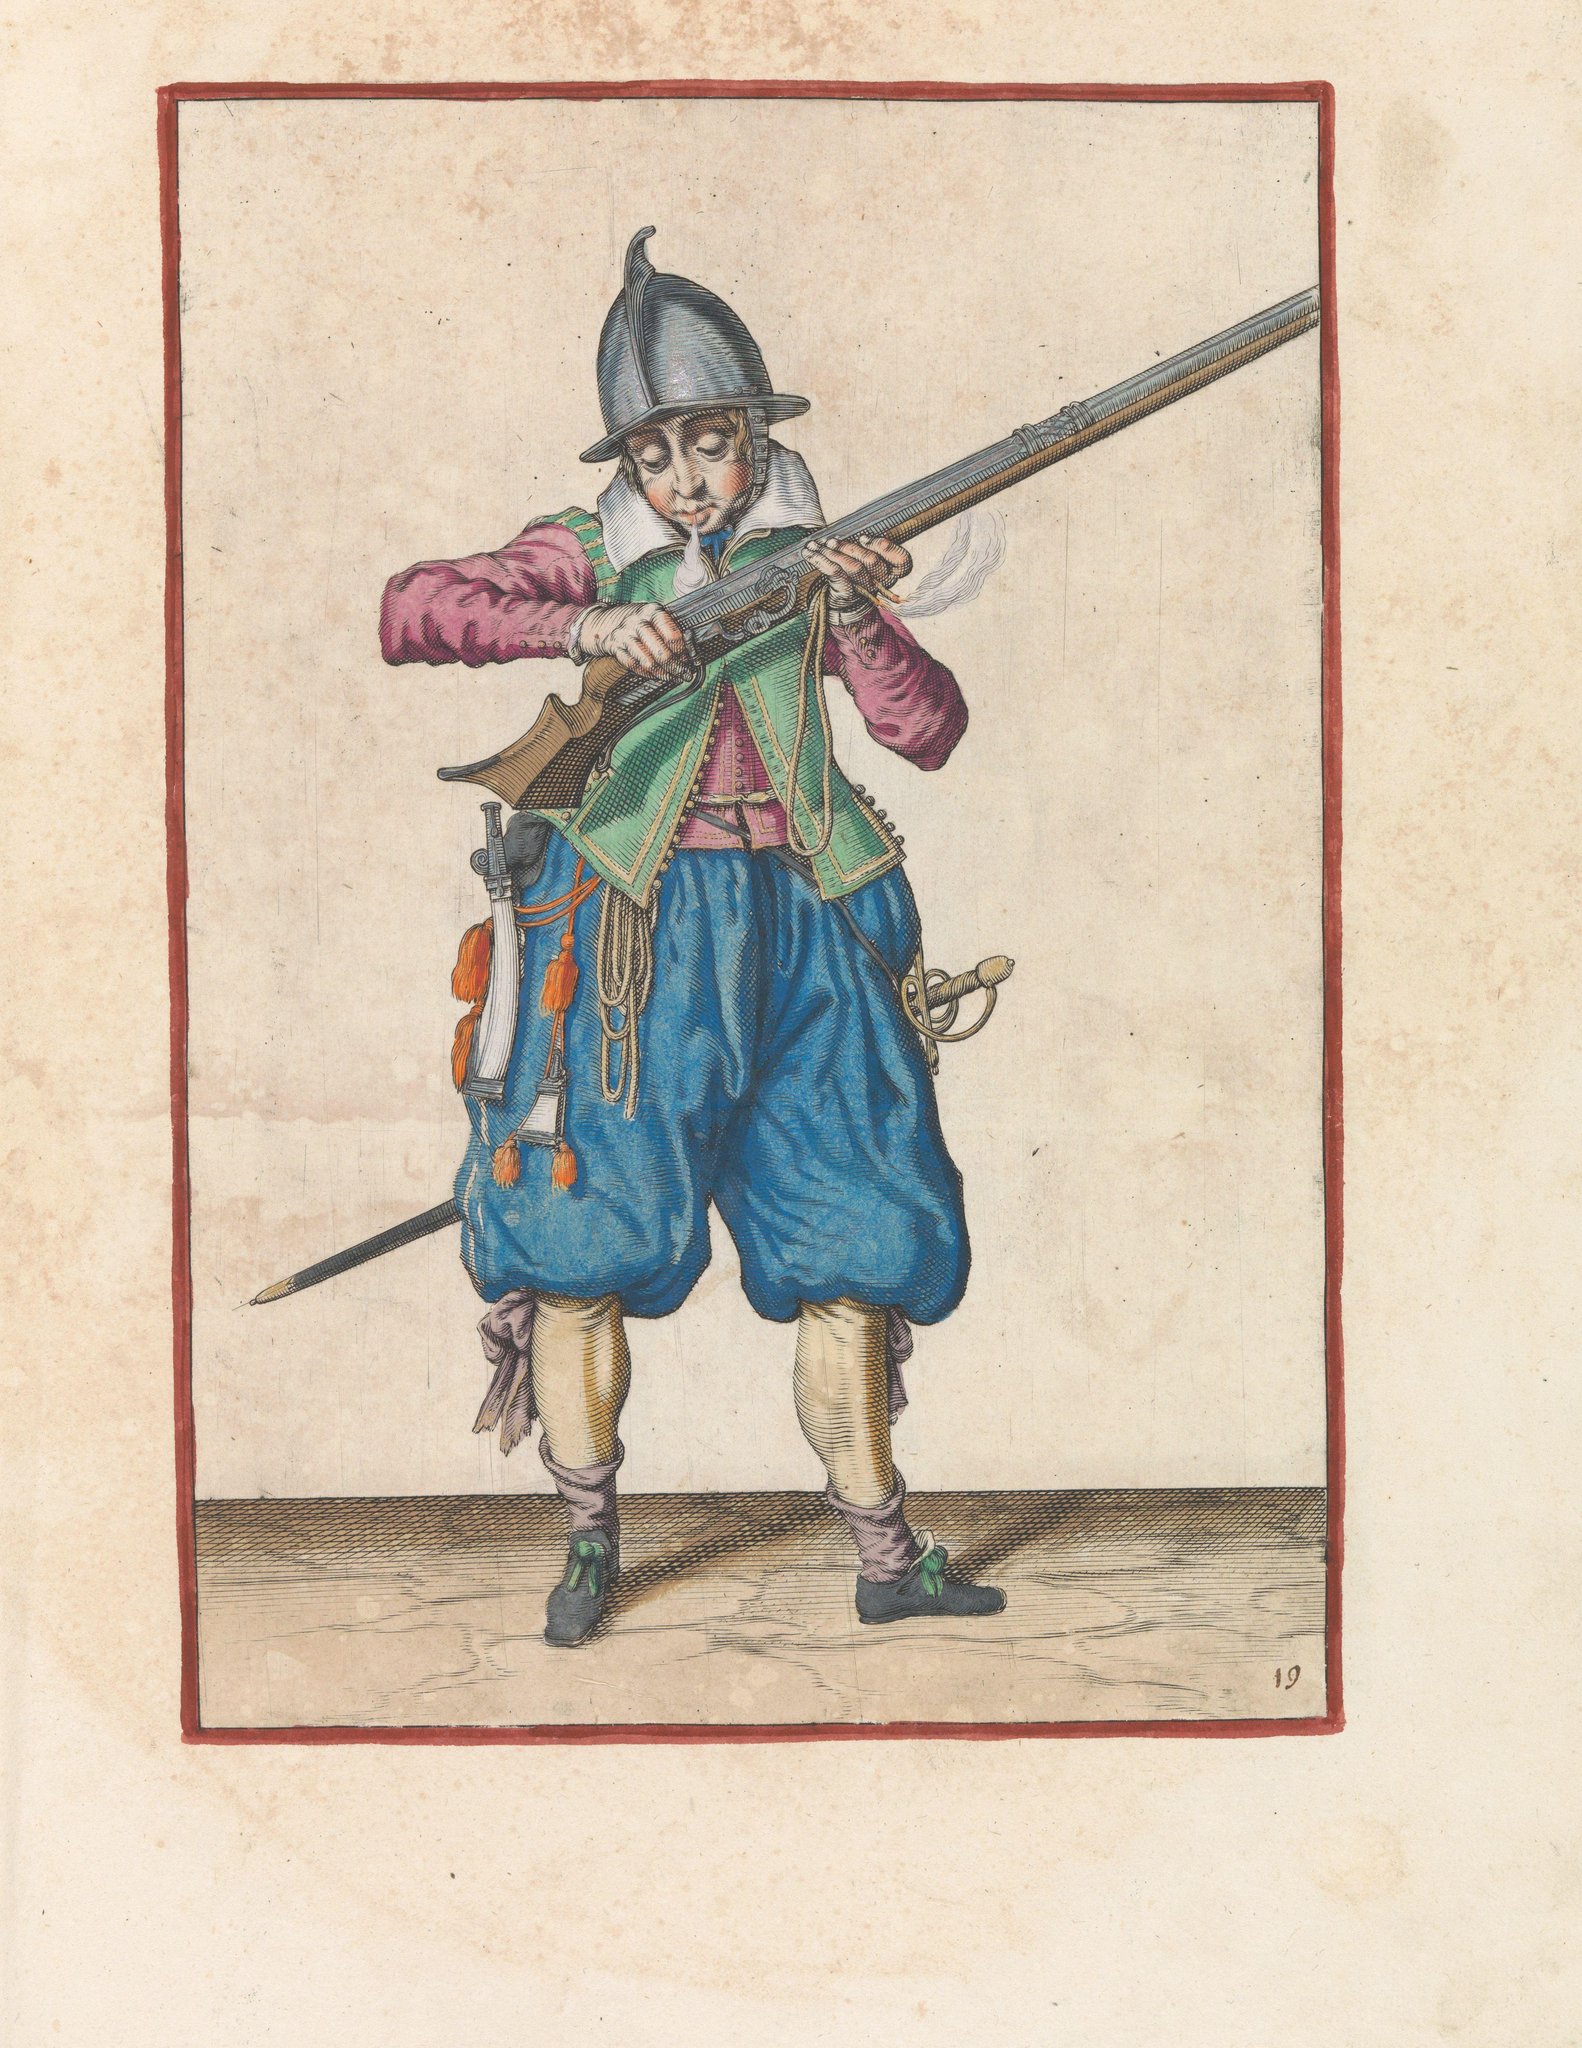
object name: print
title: Corte onderwysinghe op de figuerliicke afbeeldinghe, belanghende t'rechte ghebruyck des Roers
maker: jacques de gheyn (ii)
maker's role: painter, print maker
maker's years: 1565-1629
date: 1597-1607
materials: paper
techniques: engraving, hand coloring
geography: the hague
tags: handling of weapons ~ military training, firearms: rifle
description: Een soldaat, ten voeten uit, die met beide handen een roer (een bepaald type vuurwapen) bij zijn mond houdt en erover blaast, om eventueel buiten de pan (het kruitreservoir) gevallen kruit ervan af te krijgen. In zijn linkerhand behalve de loop van het roer ook een brandende lont. Deze prent is onderdeel van de reeks van 42 met de hand genummerde prenten van roerschutters in de Wapenhandelinghe.